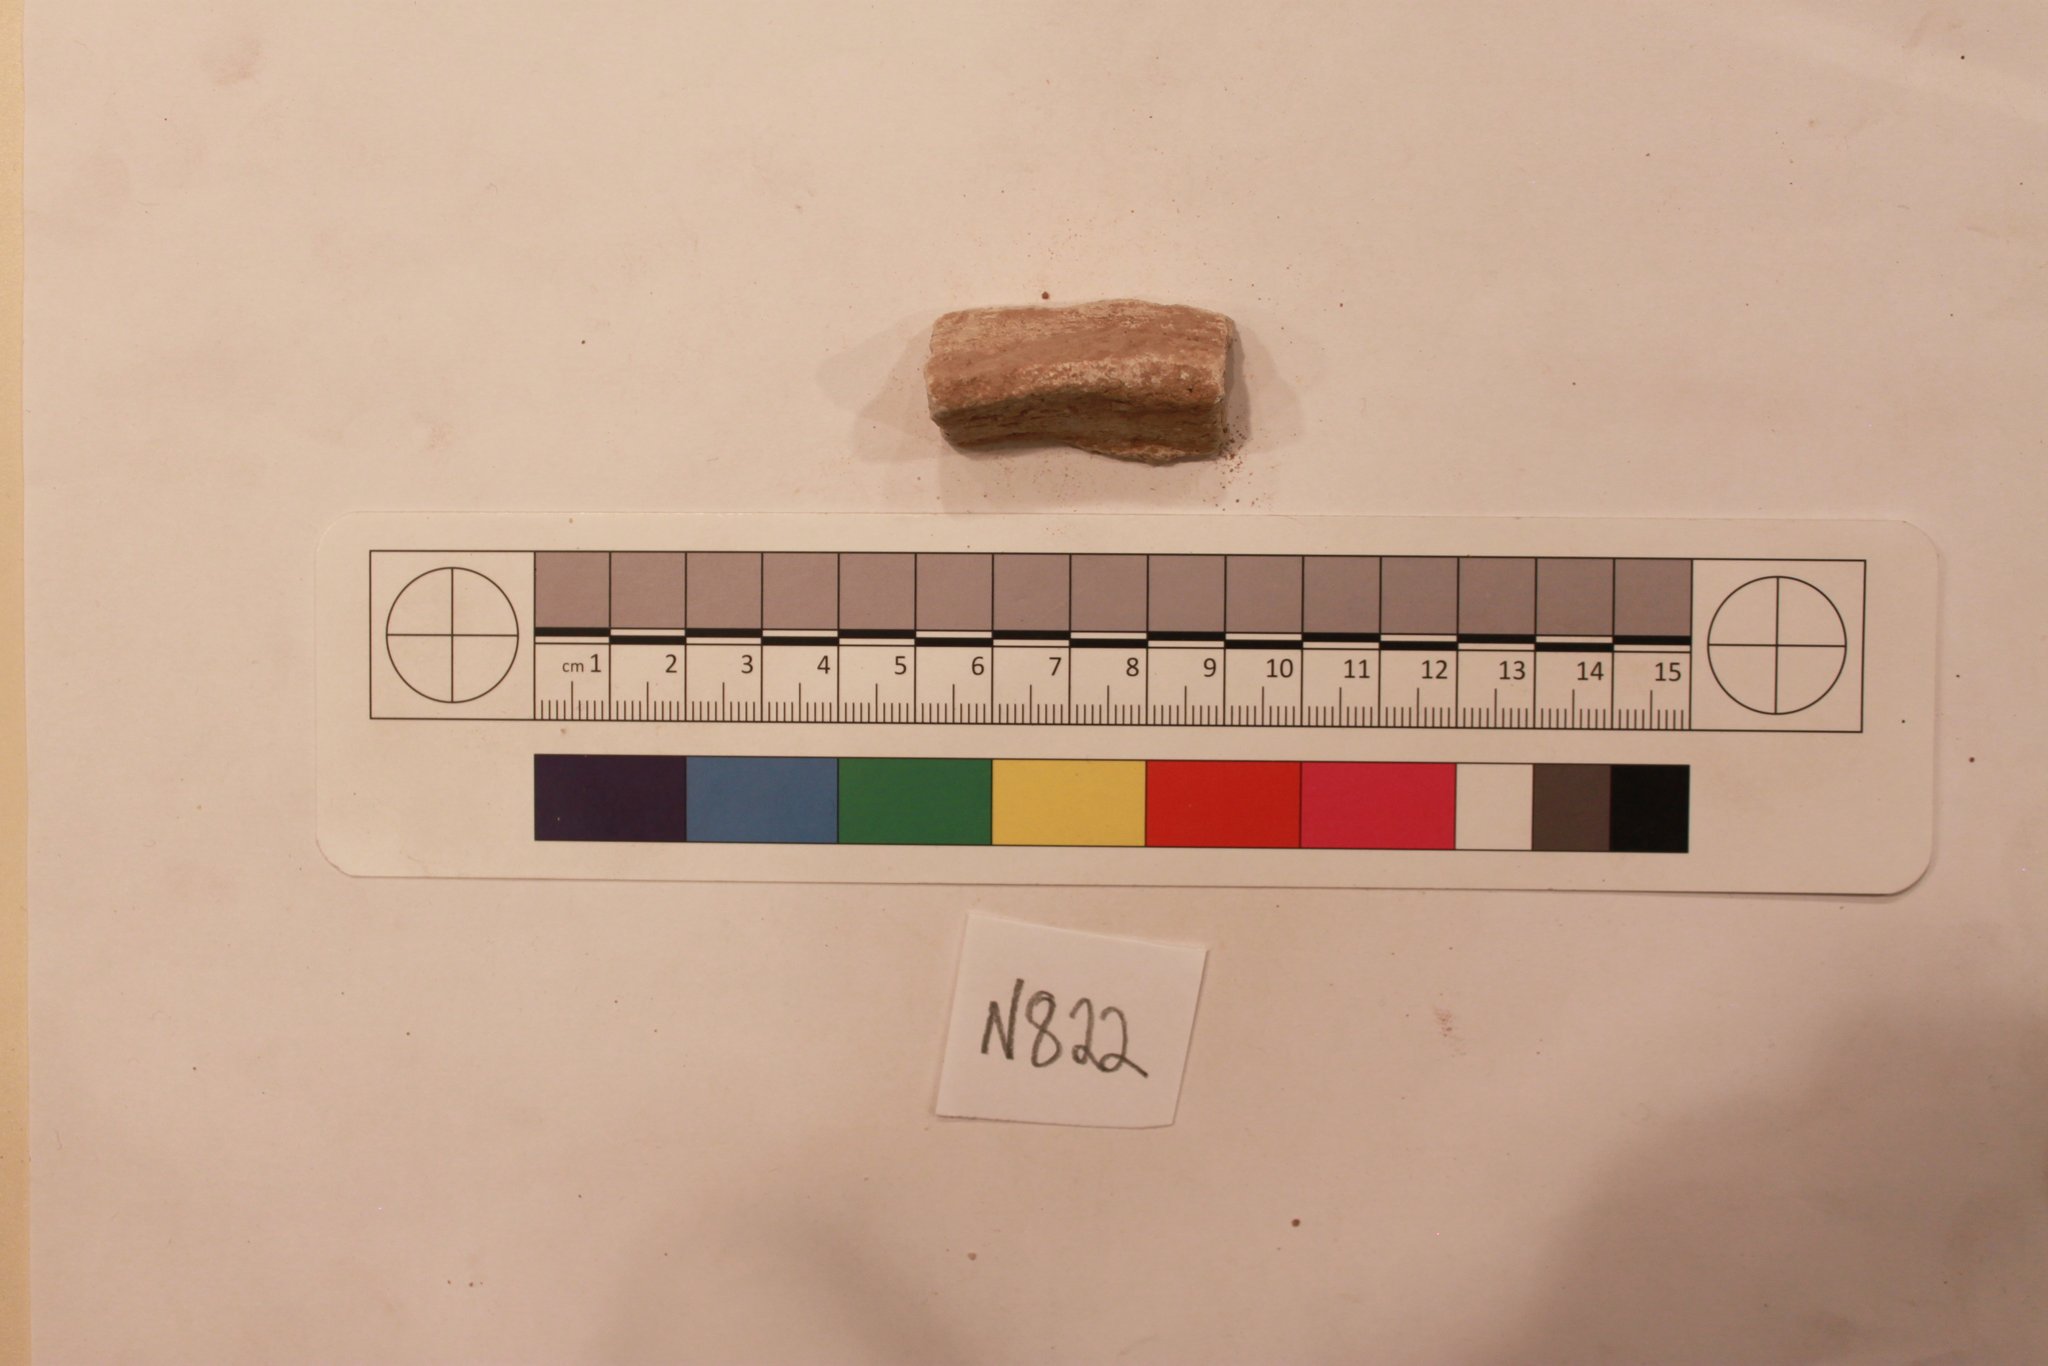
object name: fragment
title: Stucco Fragment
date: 701-1200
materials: plaster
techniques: carving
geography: iran